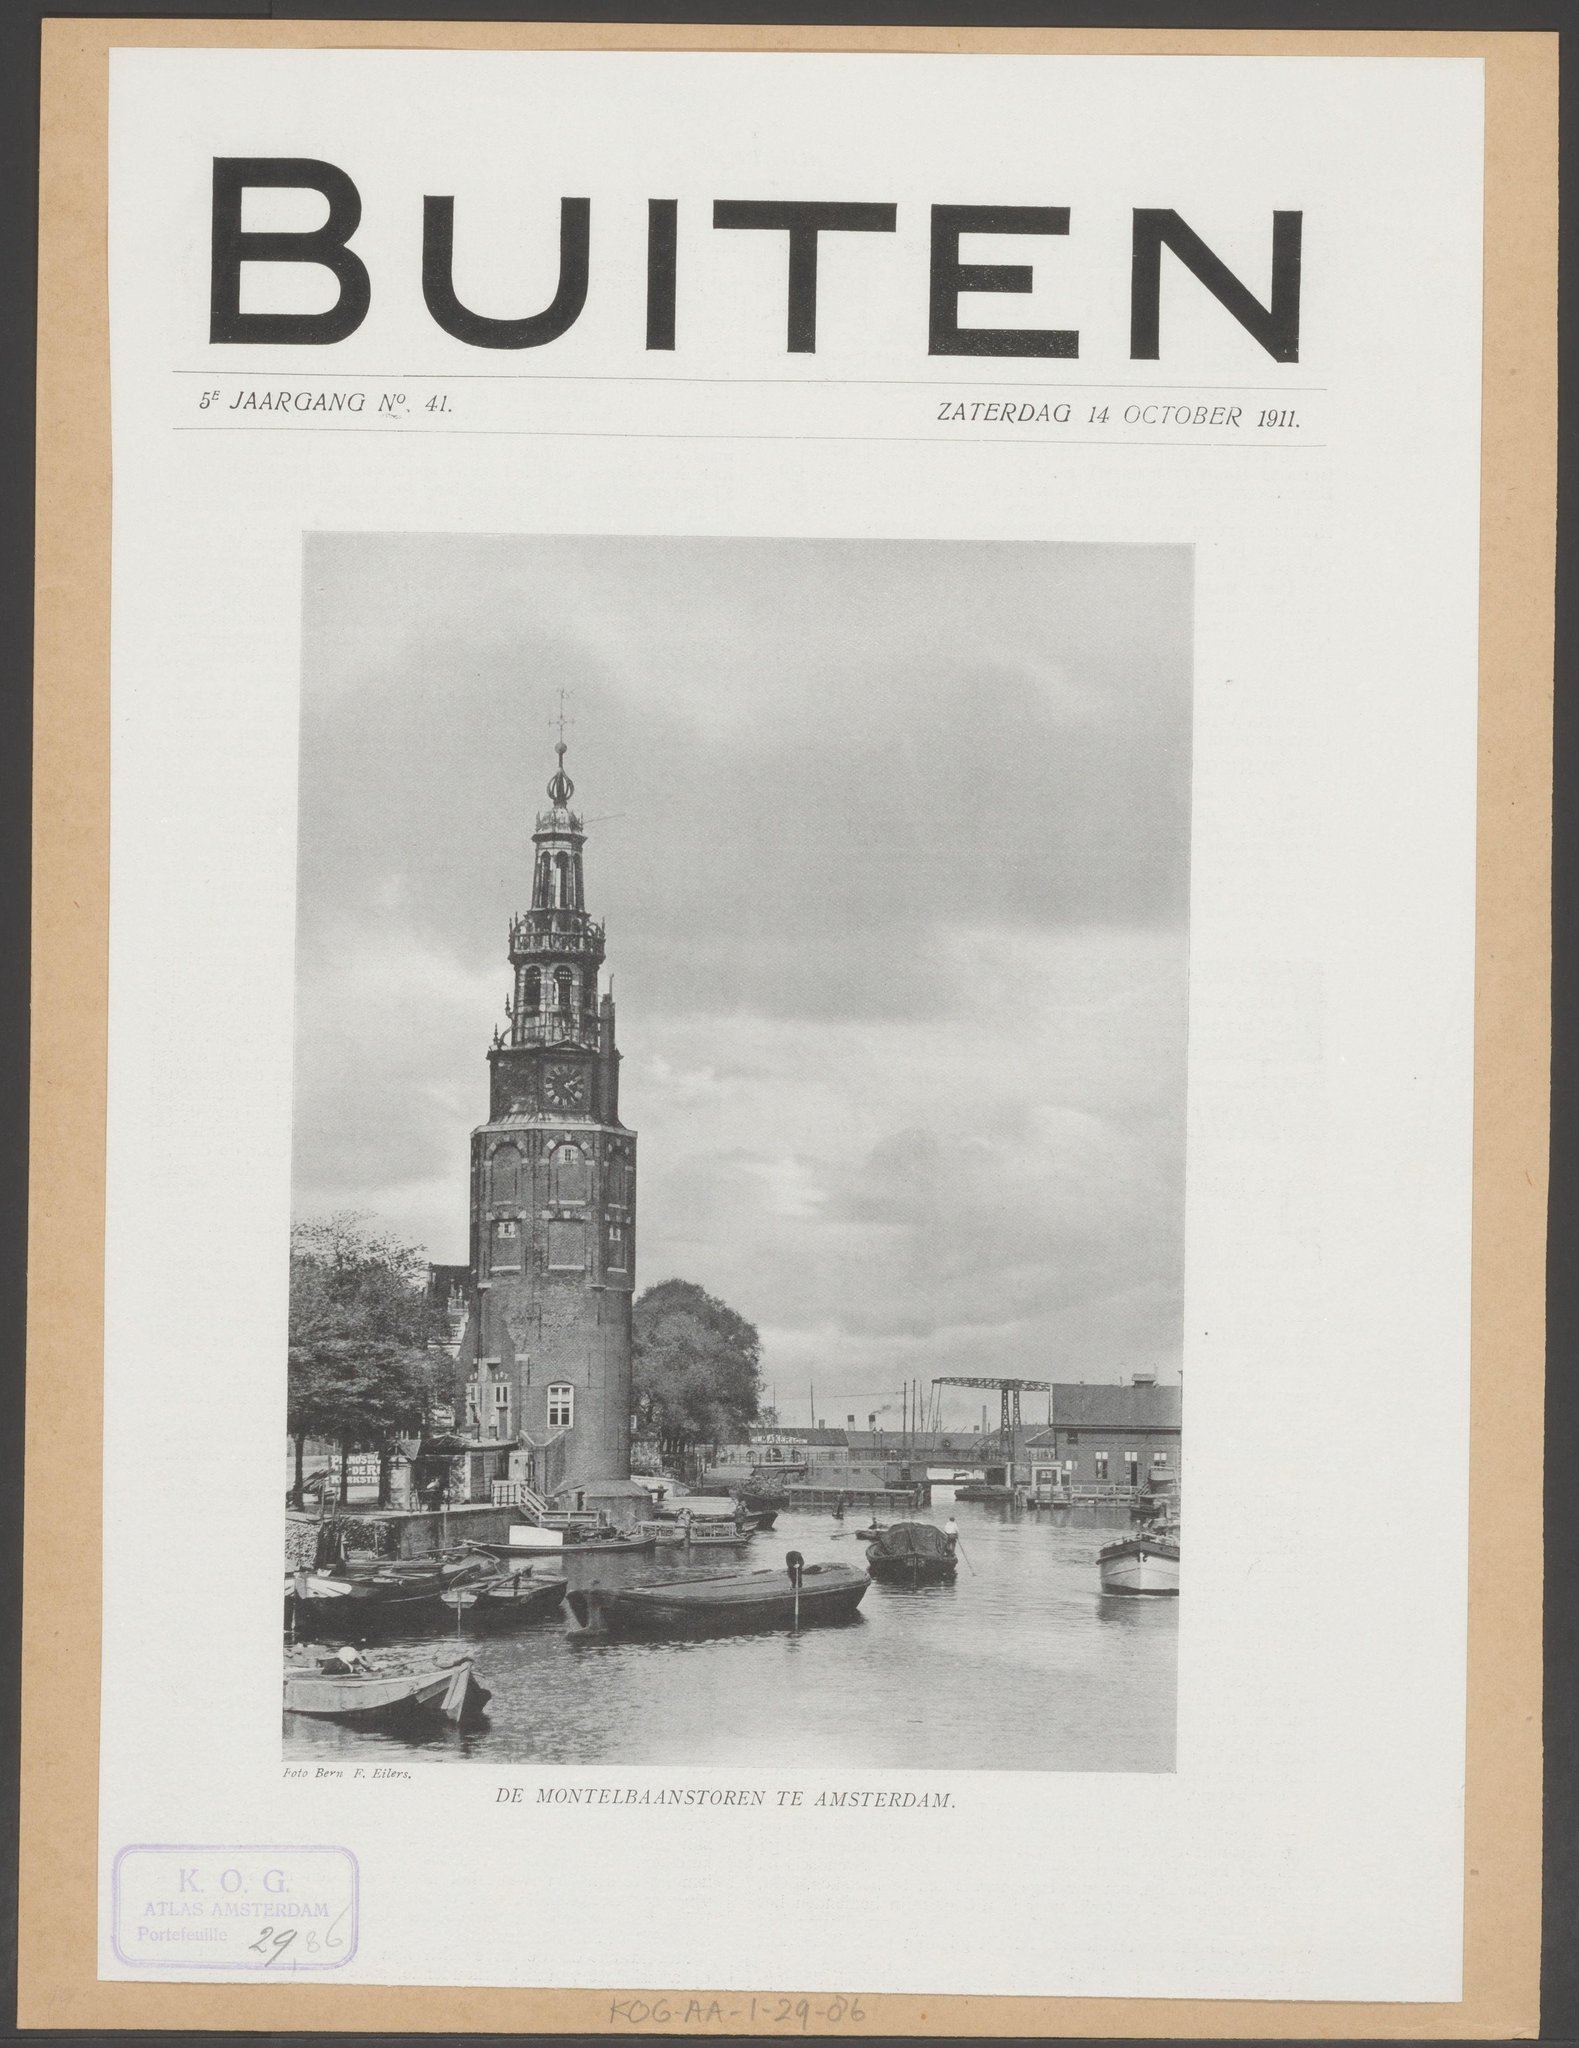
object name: titelblad, titelpagina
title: Titelpagina voor: Buiten, 14 oktober 1911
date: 1911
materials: paper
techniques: letterpress printing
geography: amsterdam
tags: tower, clock tower ~ monumental adornment, traffic on the water, canals, waters (in city) (+ city(-scape) with figures, staffage)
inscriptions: collector's mark: Lugt 1641b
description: Onderwerpsrubriek binnen de Atlas Amsterdam: Montelbaanstoren.